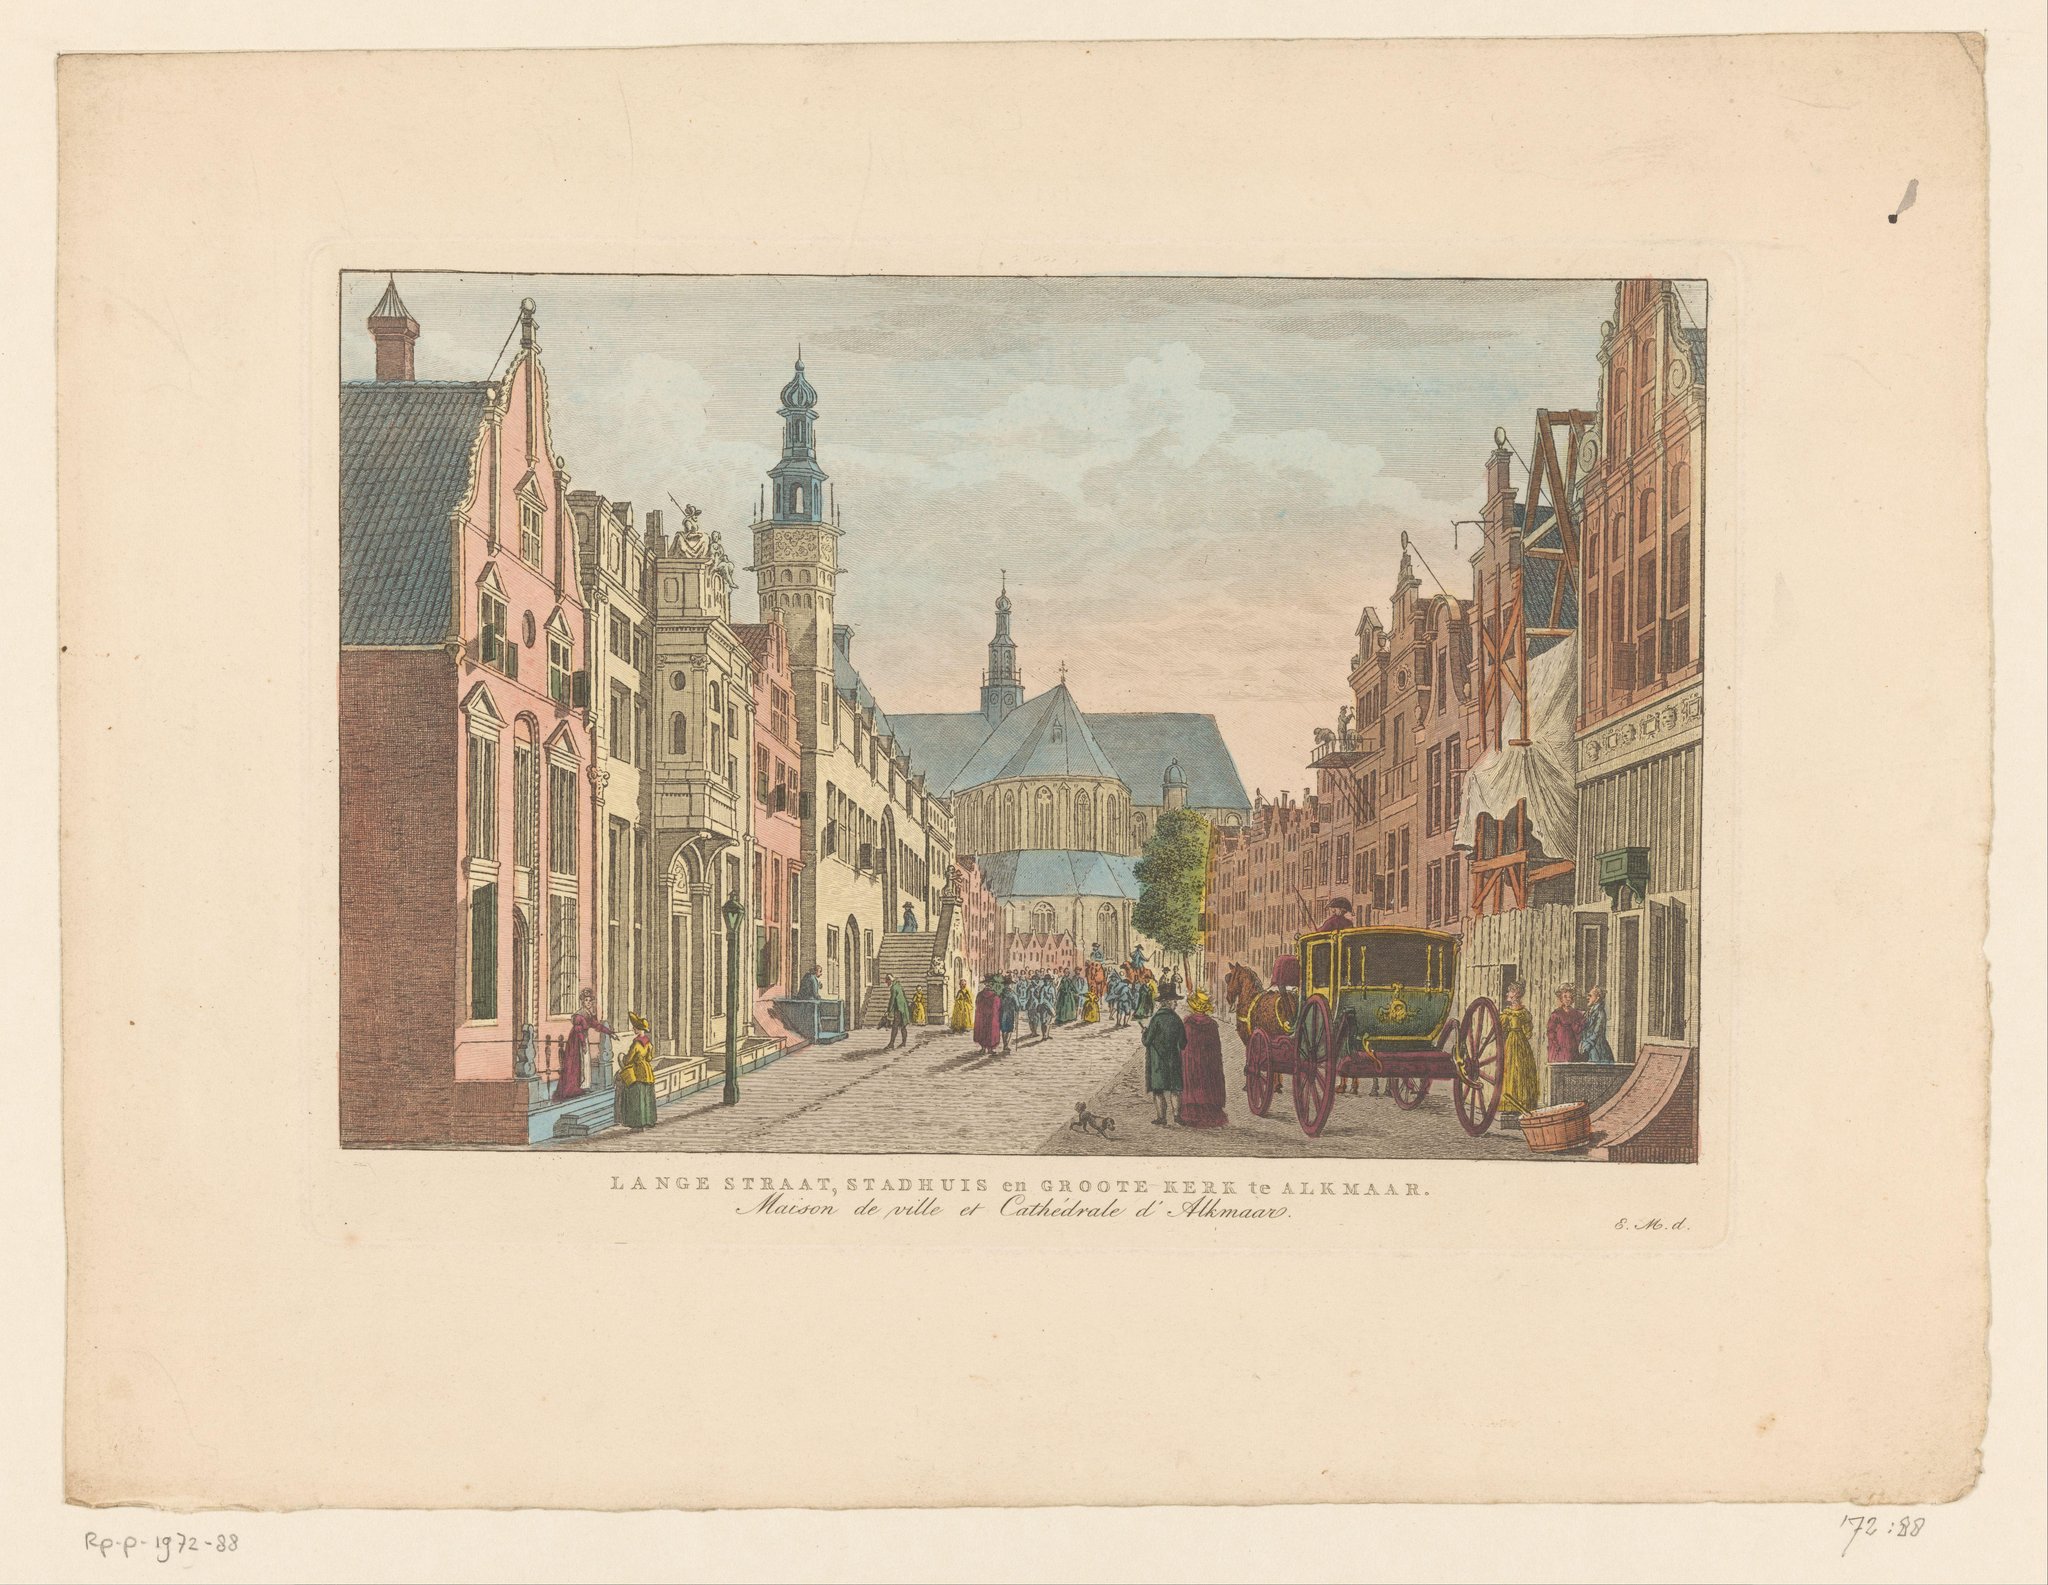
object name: print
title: Gezicht op de Langestraat, het Stadhuis en de Grote Kerk te Alkmaar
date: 1786-1792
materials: paper, watercolor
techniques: etching, hand coloring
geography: amsterdam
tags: city-view, and landscape with man-made constructions (+ city(-scape) with figures, staffage)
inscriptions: collector's mark: Lugt 2228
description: Huidige staat van prent uitgegeven als onderdeel van een plaatwerk uit ca. 1824-1825 met 74 (ongenummerde) platen van de belangrijkste topografische gezichten en verschillende zeden en gewoonten in het Verenigd Koninkrijk der Nederlanden, getiteld 'Tableau des principales vues des palais et édifices : représentations et des coutumes et usages, dans les provinces septentrionales du Royaume des Pays-Bas'. Eerdere staat gebruikt in: Vaderlandsche gezichten, of afbeeldingen van den tegenwoordigen staat der Vereenigde Nederlanden (…). Amsterdam: Hendrik Gartman, Willem Vermandel en Jan Willem Smit, 1786-1792. Uitgegeven in afleveringen met ieder een eigen bifolium en inhoudsopgave. Alle prenten in deze publicatie zijn gegraveerd door Carel Frederik Bendorp (I) en, in de meeste gevallen, gebaseerd op tekeningen van Jan Bulthuis.